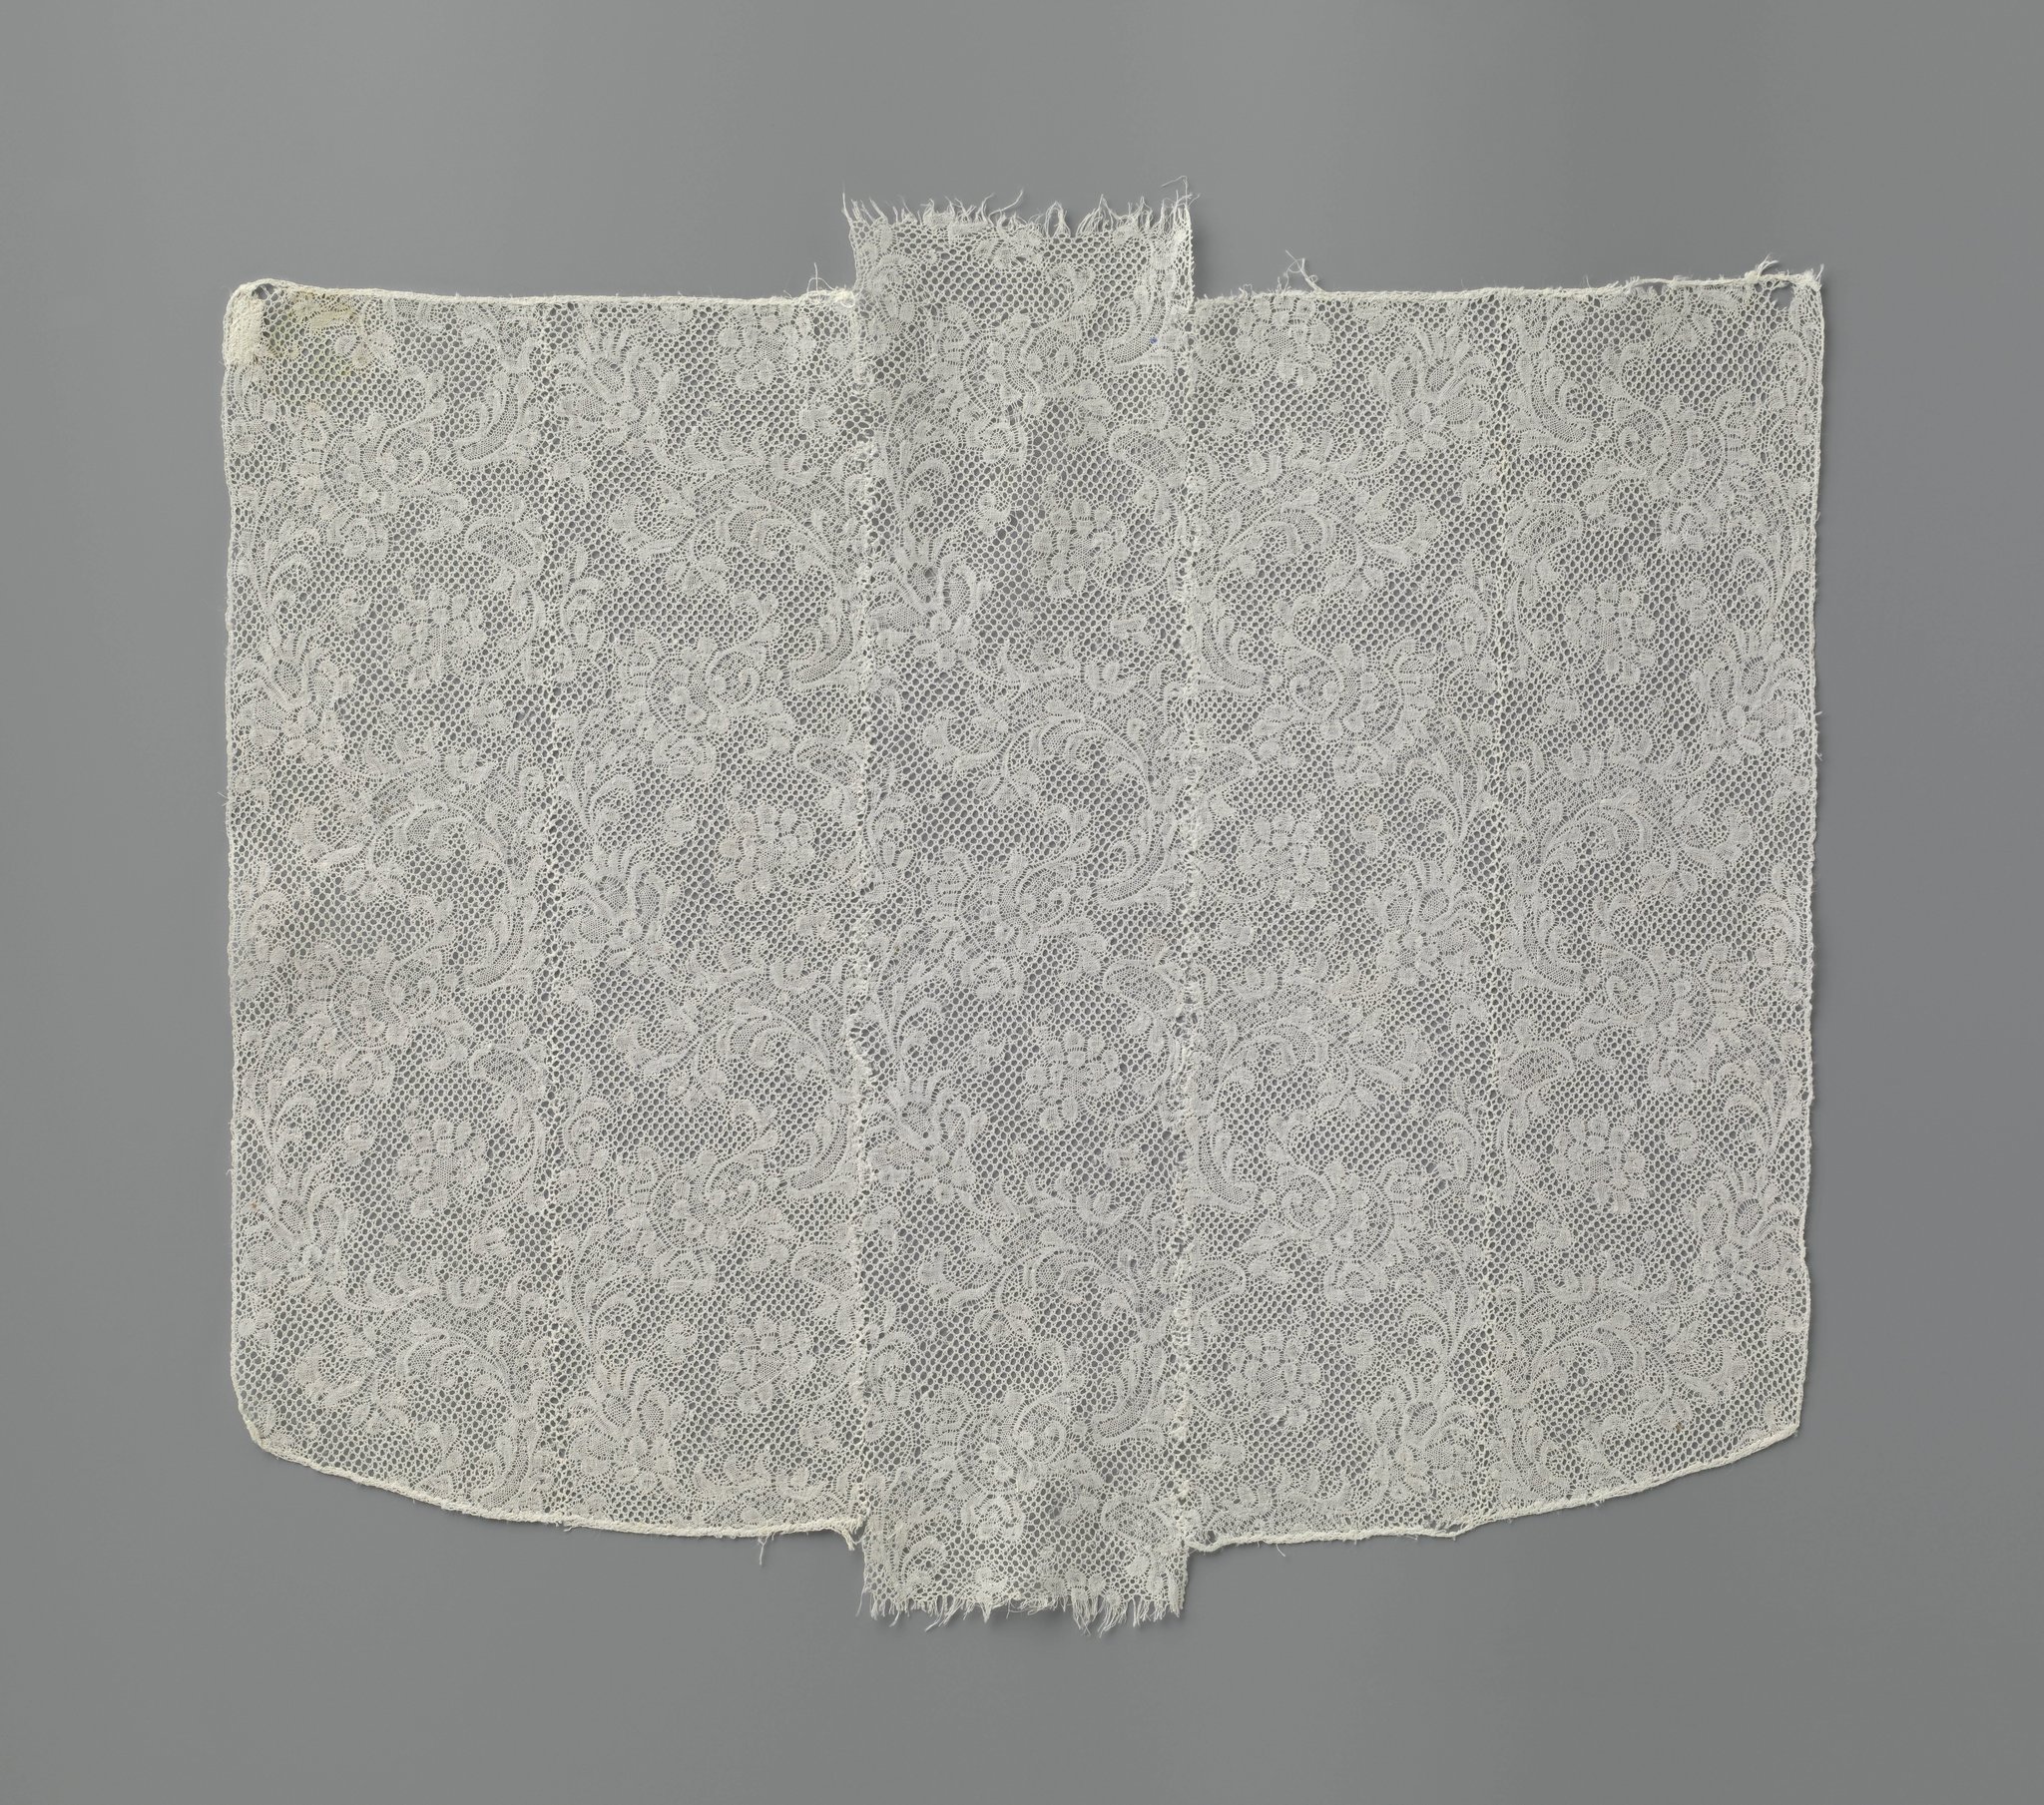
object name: vest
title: Vest of beukje van kloskant met fijne voluten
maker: Anonymous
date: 1750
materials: linen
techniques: lace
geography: southern netherlands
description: Vest of beukje van naturelkleurige kloskant: Binche-kant. Rechthoekig model, uit vijf rechte strookjes samengesteld. Op een traliegrond, een vijfgaatjesgrond, staat een diep golvende rank, die voortkomt uit een C-voluut. Die vervolgens via een palmet doorloopt als een hoorn met brede rand om daarna weer te beginnen met de C-voluut. De motieven zijn gemaakt in netslag met opengewerkte randjes en in netslag. Als siergrond is onder andere in de c-voluut een sneeuwvlokkengrond toegepast. De zijden zijn afgewerkt met een zoompje, met uitzondering van de middelste strook. Deze is iets langer dan de andere stroken en steekt aan beide zijden van het vestje iets uit. De korte zijden van deze uitstekende strook zijn niet afgewerkt.